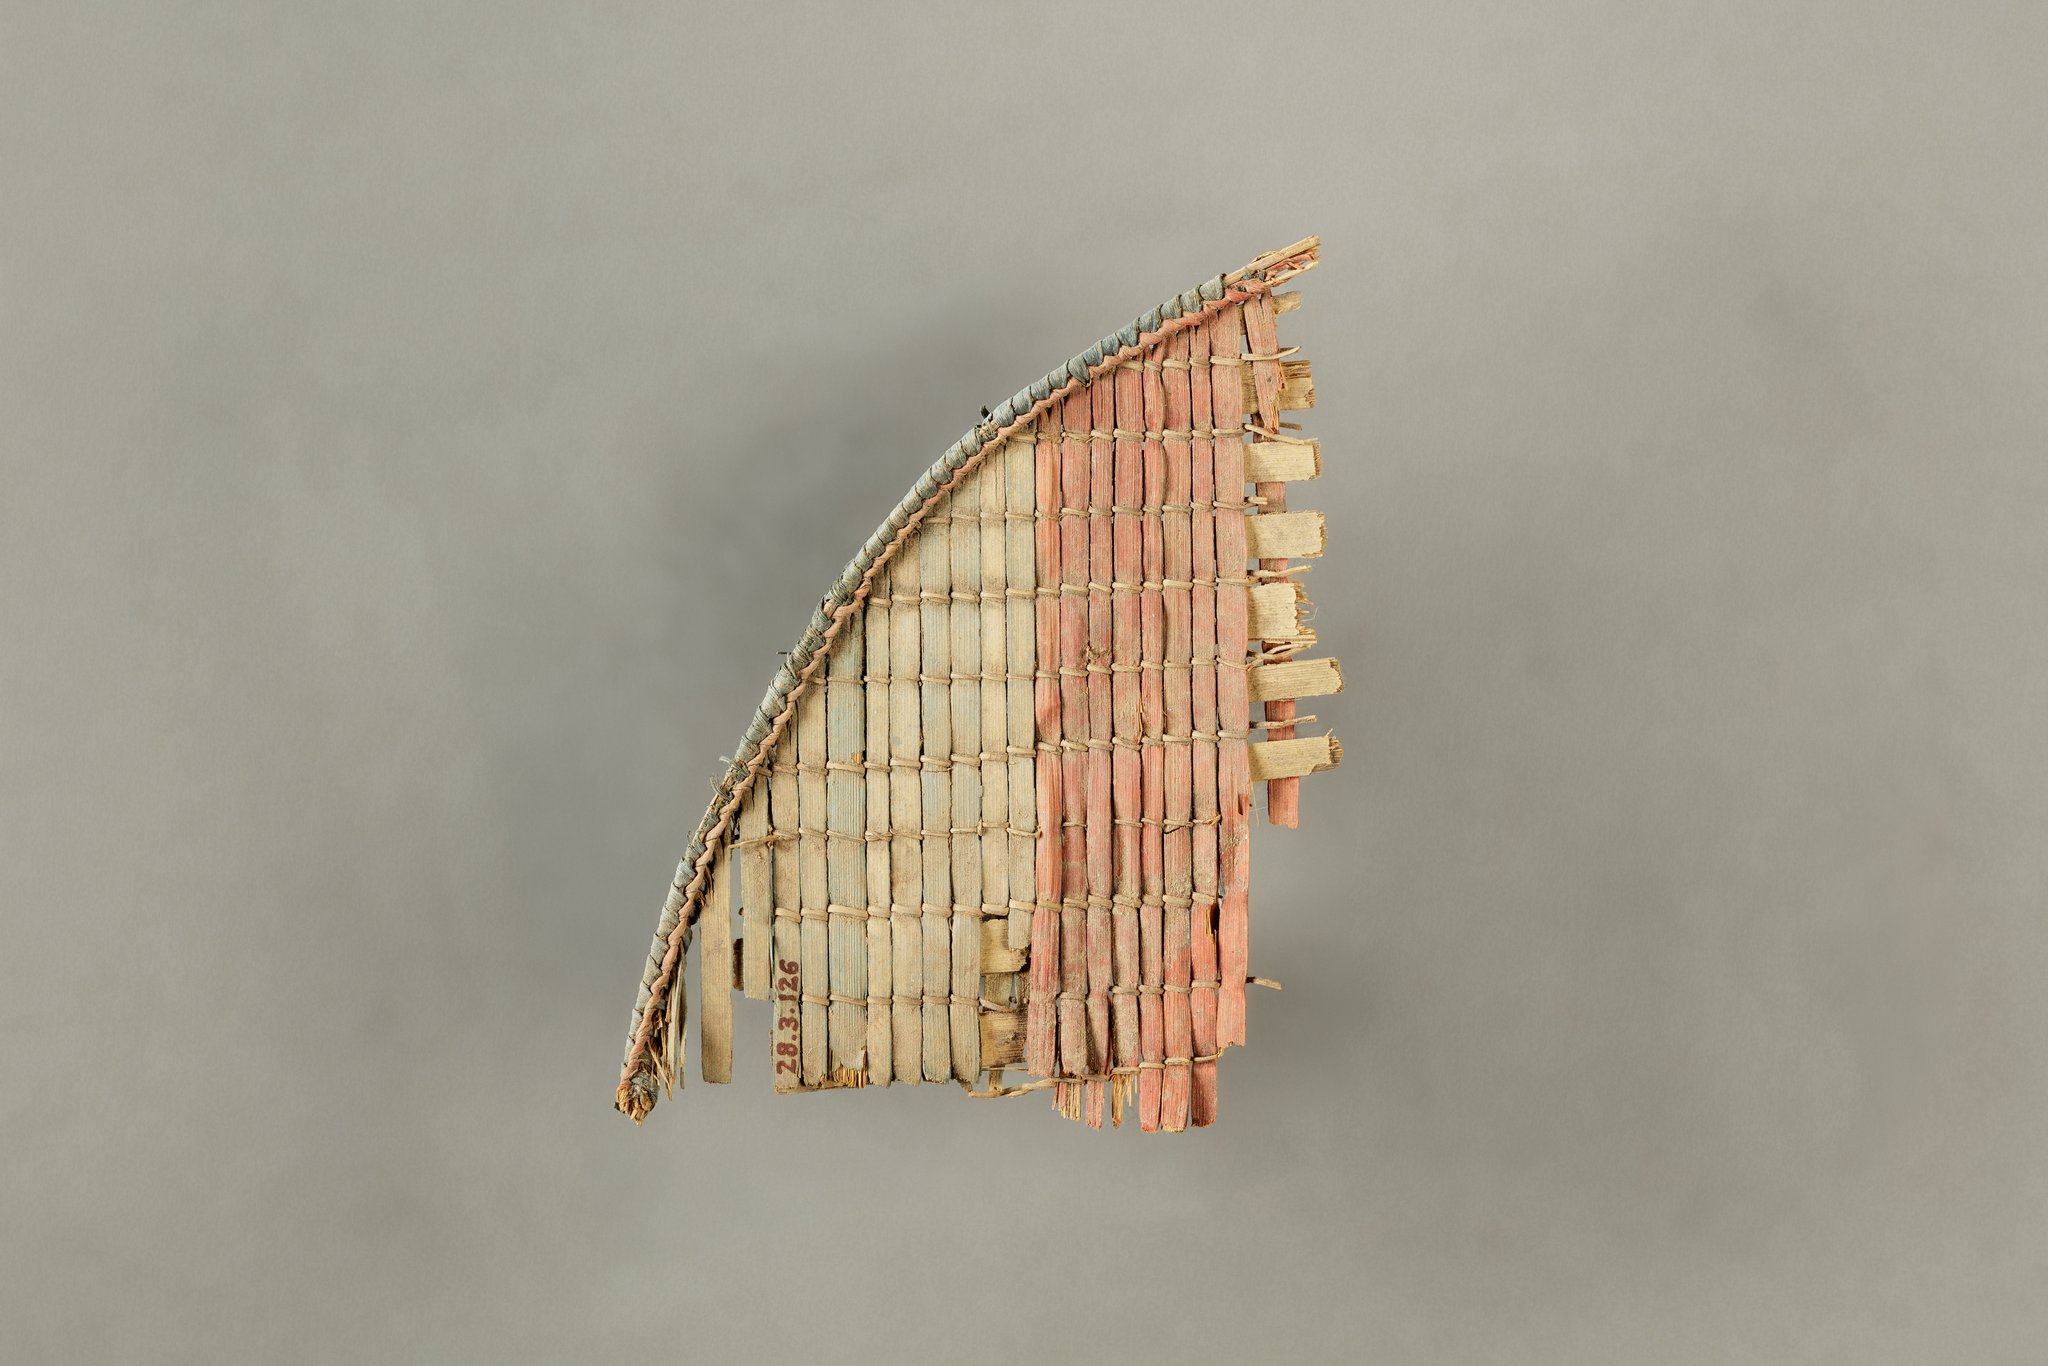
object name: fan fragment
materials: leaf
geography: egypt